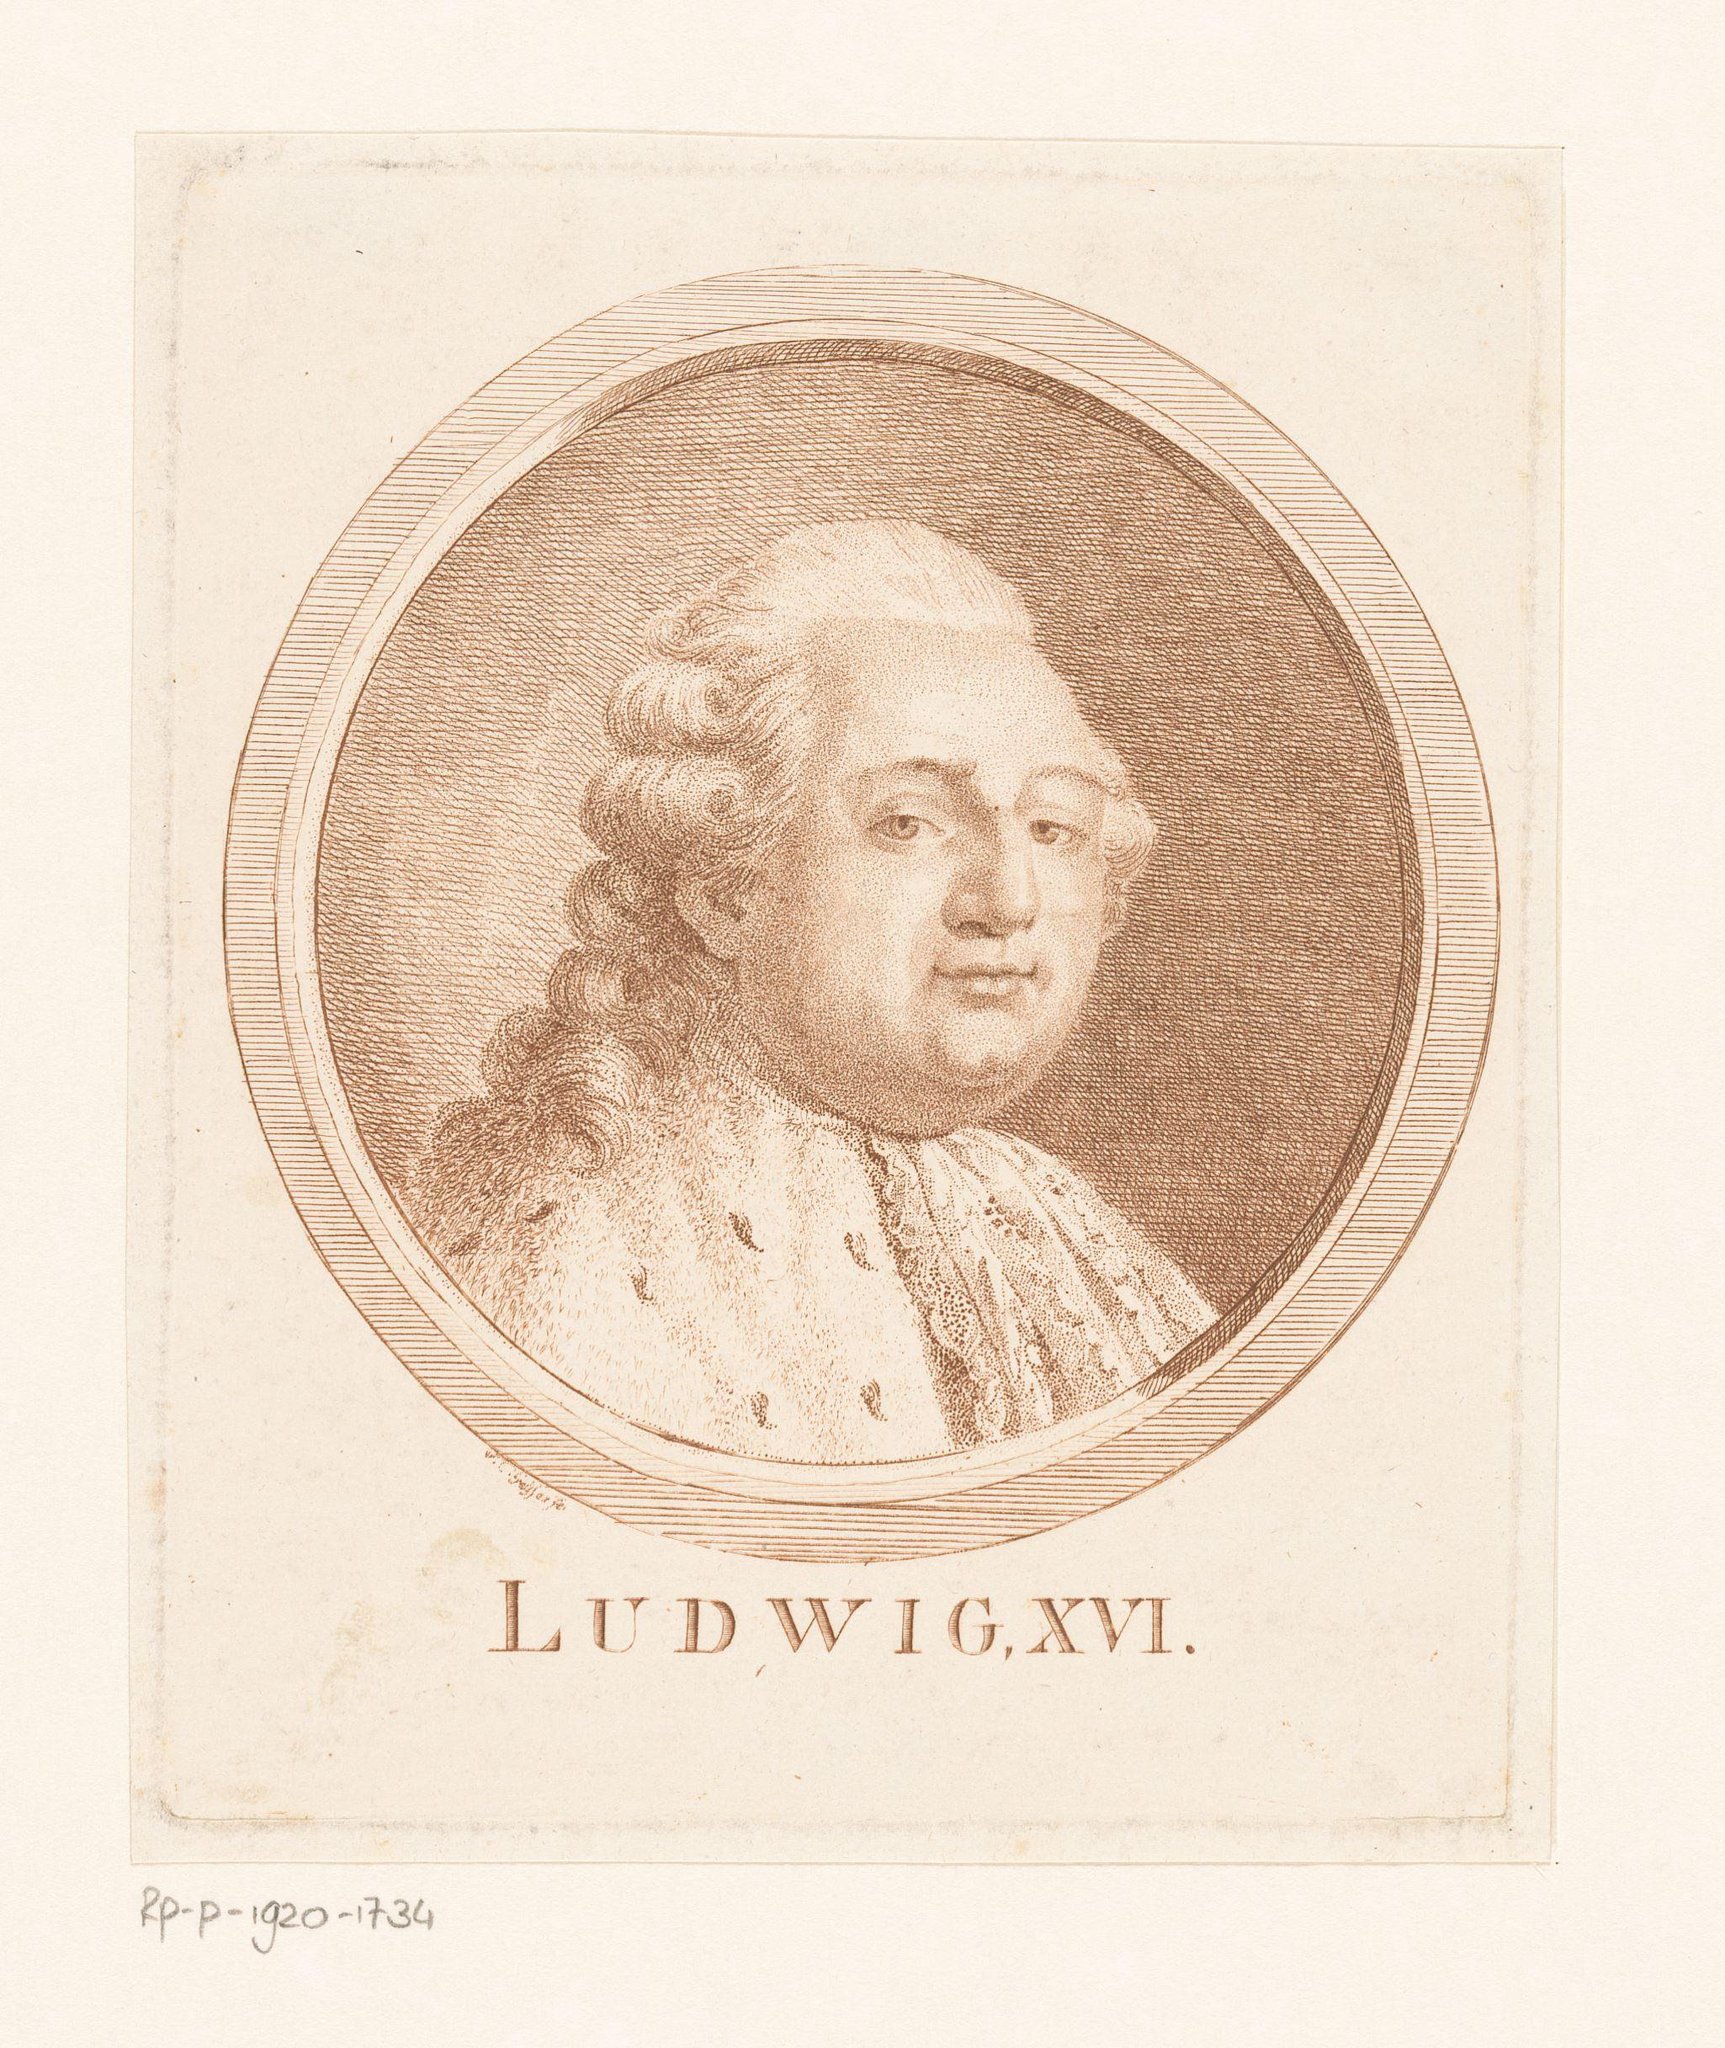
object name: print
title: Portret van Lodewijk XVI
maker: friedrich christian gottlieb geyser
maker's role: print maker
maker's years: 1772-1846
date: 1782-1846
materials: paper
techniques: engraving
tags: paris, lodewijk xvi (koning van frankrijk), historical persons, ruler, sovereign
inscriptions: collector's mark: Lugt 2228